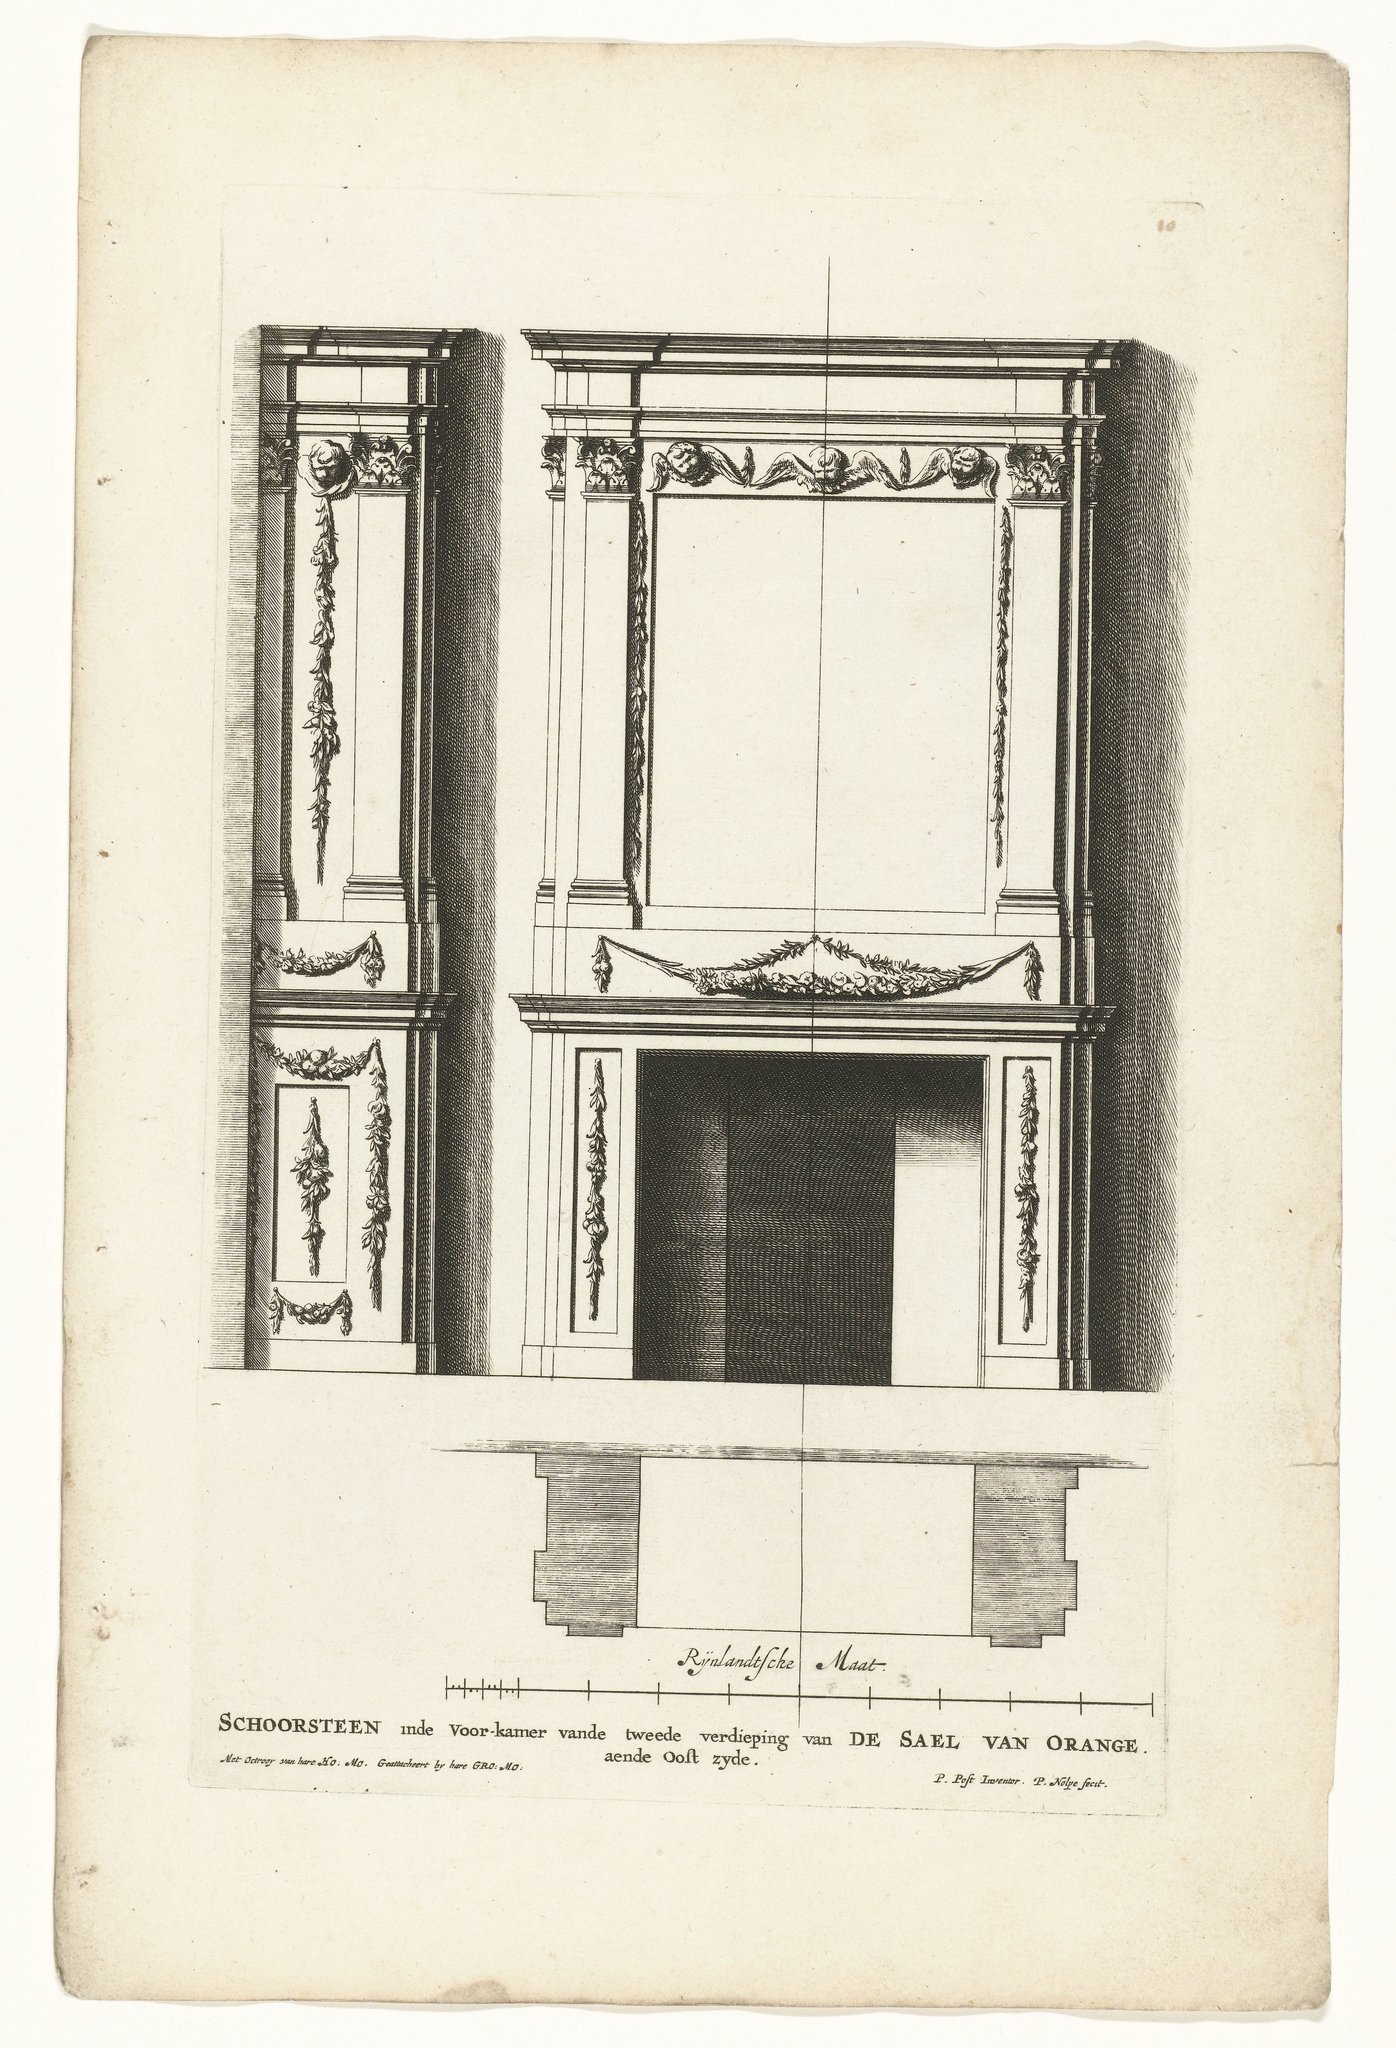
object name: print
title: Schoorsteen-Wercken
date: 1664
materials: paper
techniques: engraving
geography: the hague